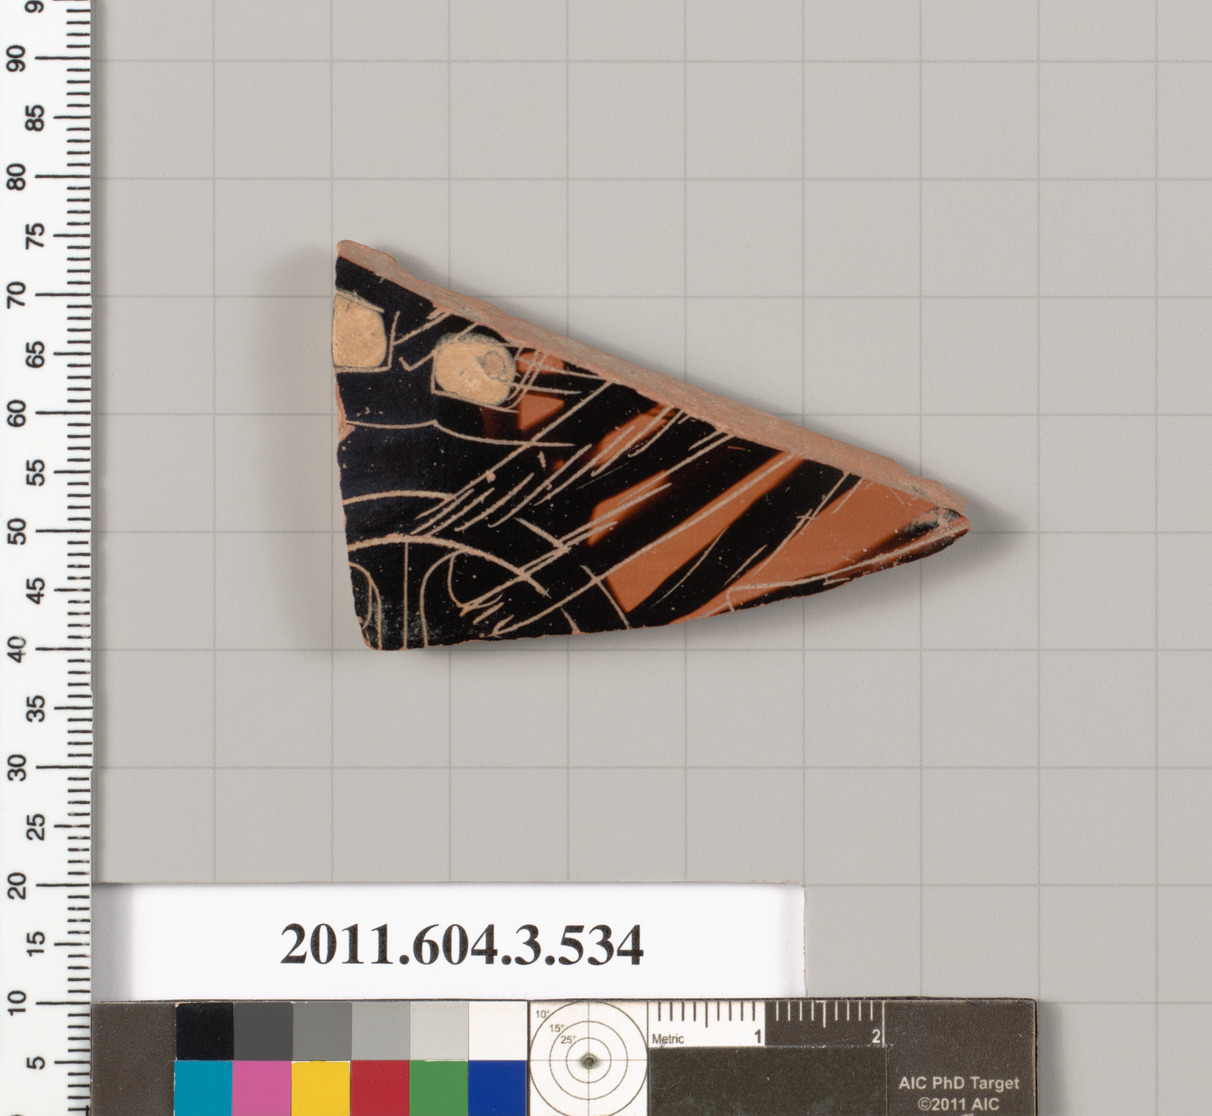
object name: column krater fragment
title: Terracotta fragment of a column-krater (bowl for mixing wine and water)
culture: greek, attic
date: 534-468 BCE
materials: terracotta